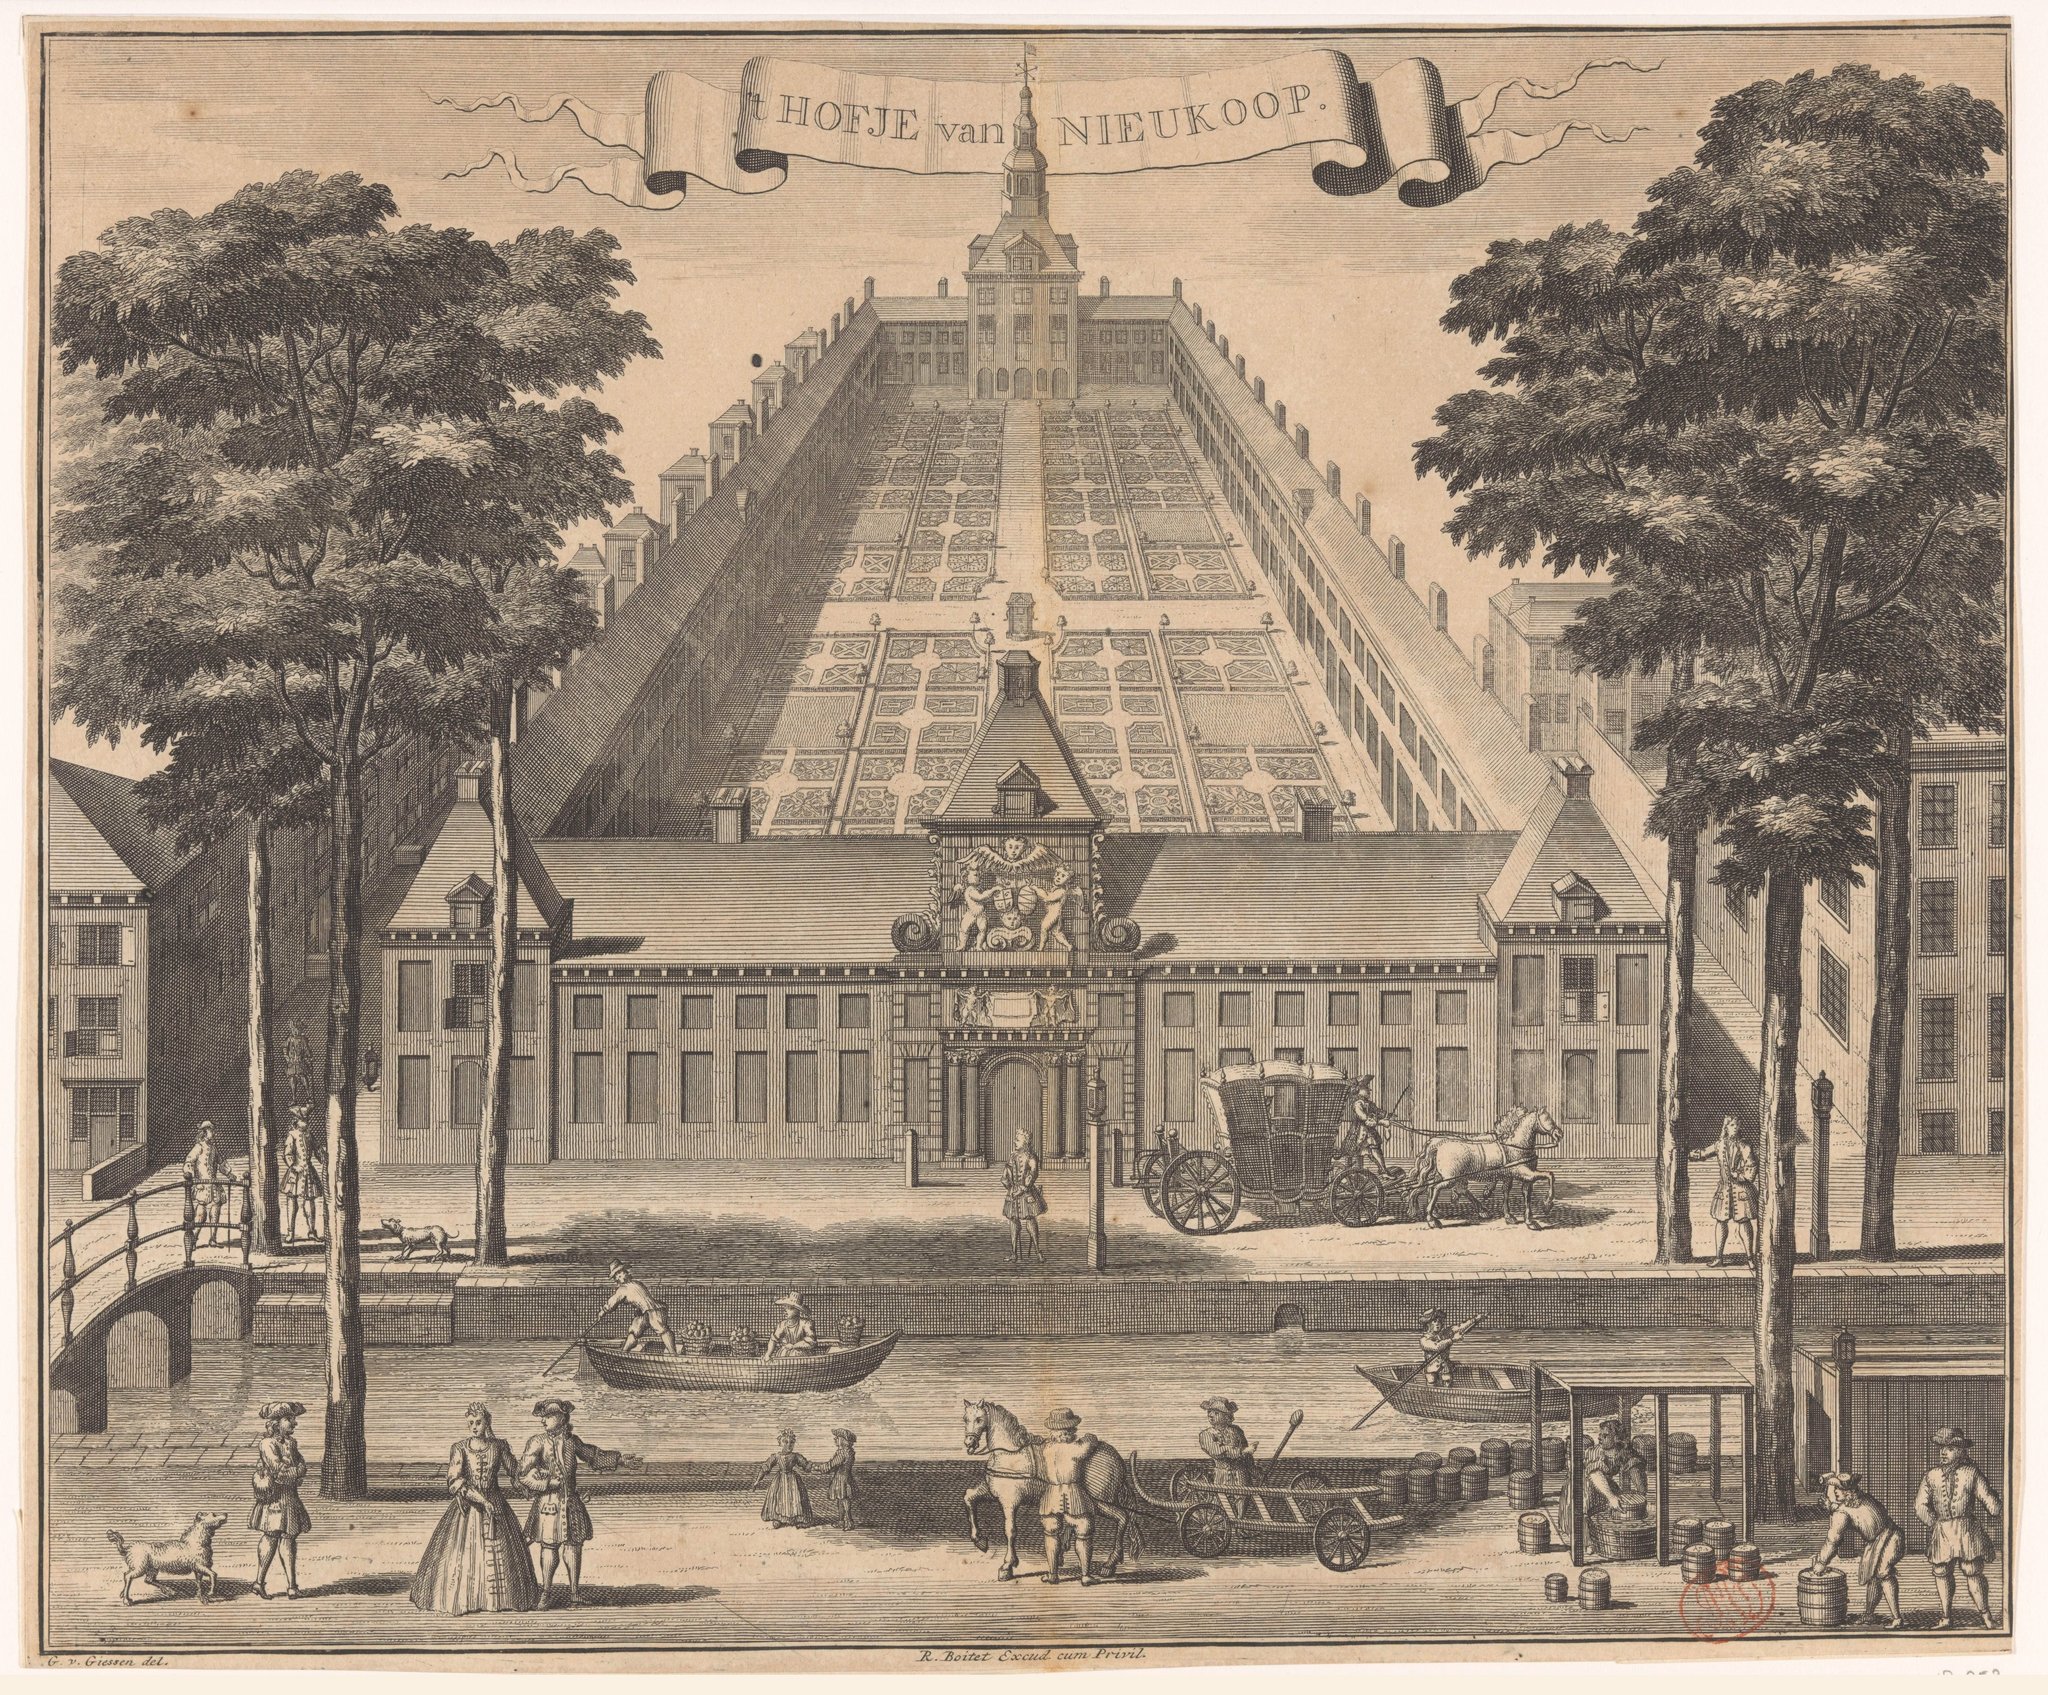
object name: print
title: Gezicht op het Hofje van Nieuwkoop te Den Haag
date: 1730-1736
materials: paper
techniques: engraving, etching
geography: the hague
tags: alms-house (dutch: 'hofje'), garden, gate, entrance, bridge, street (+ city(-scape) with figures, staffage)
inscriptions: collector's mark: Lugt 2228, collector's mark: Lugt 195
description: Gezicht op het Hofje van Nieuwkoop aan de Prinsegracht te Den Haag. Achter het poortgebouw de binnentuin met daaromheen de huisjes. Op straat verschillende figuren.